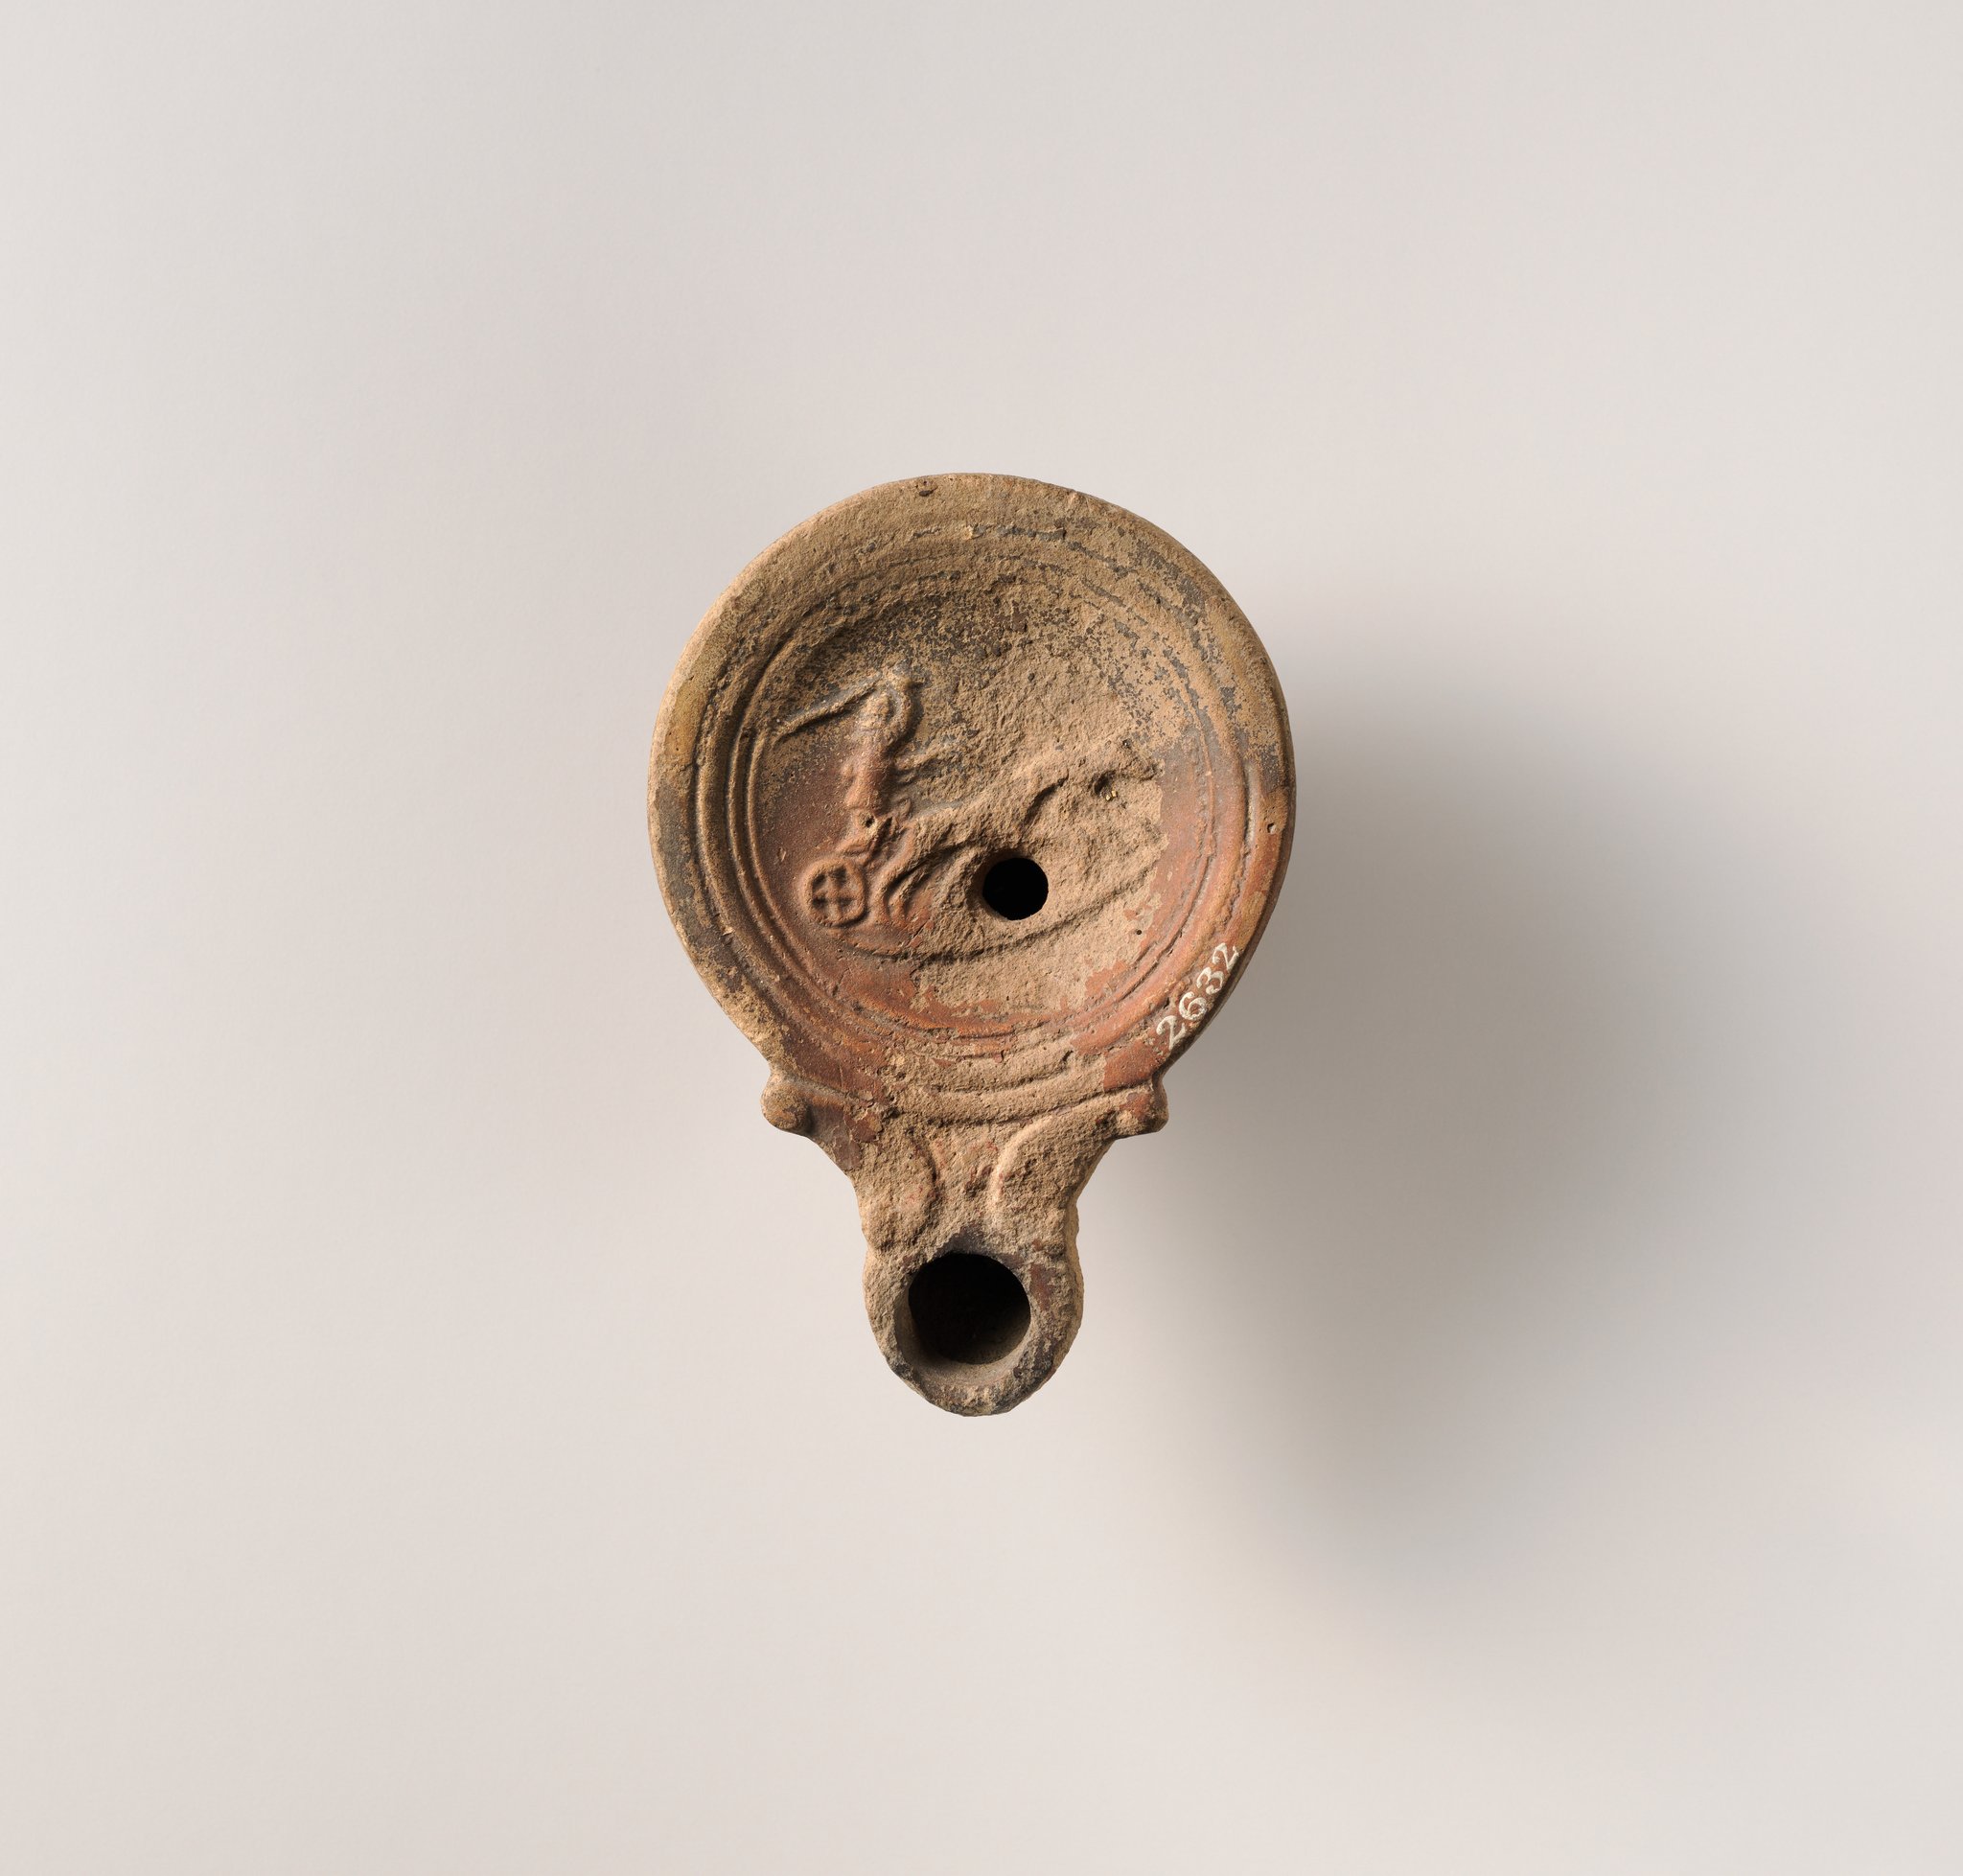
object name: lamp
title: Terracotta oil lamp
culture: roman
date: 1-100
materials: terracotta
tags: chariots